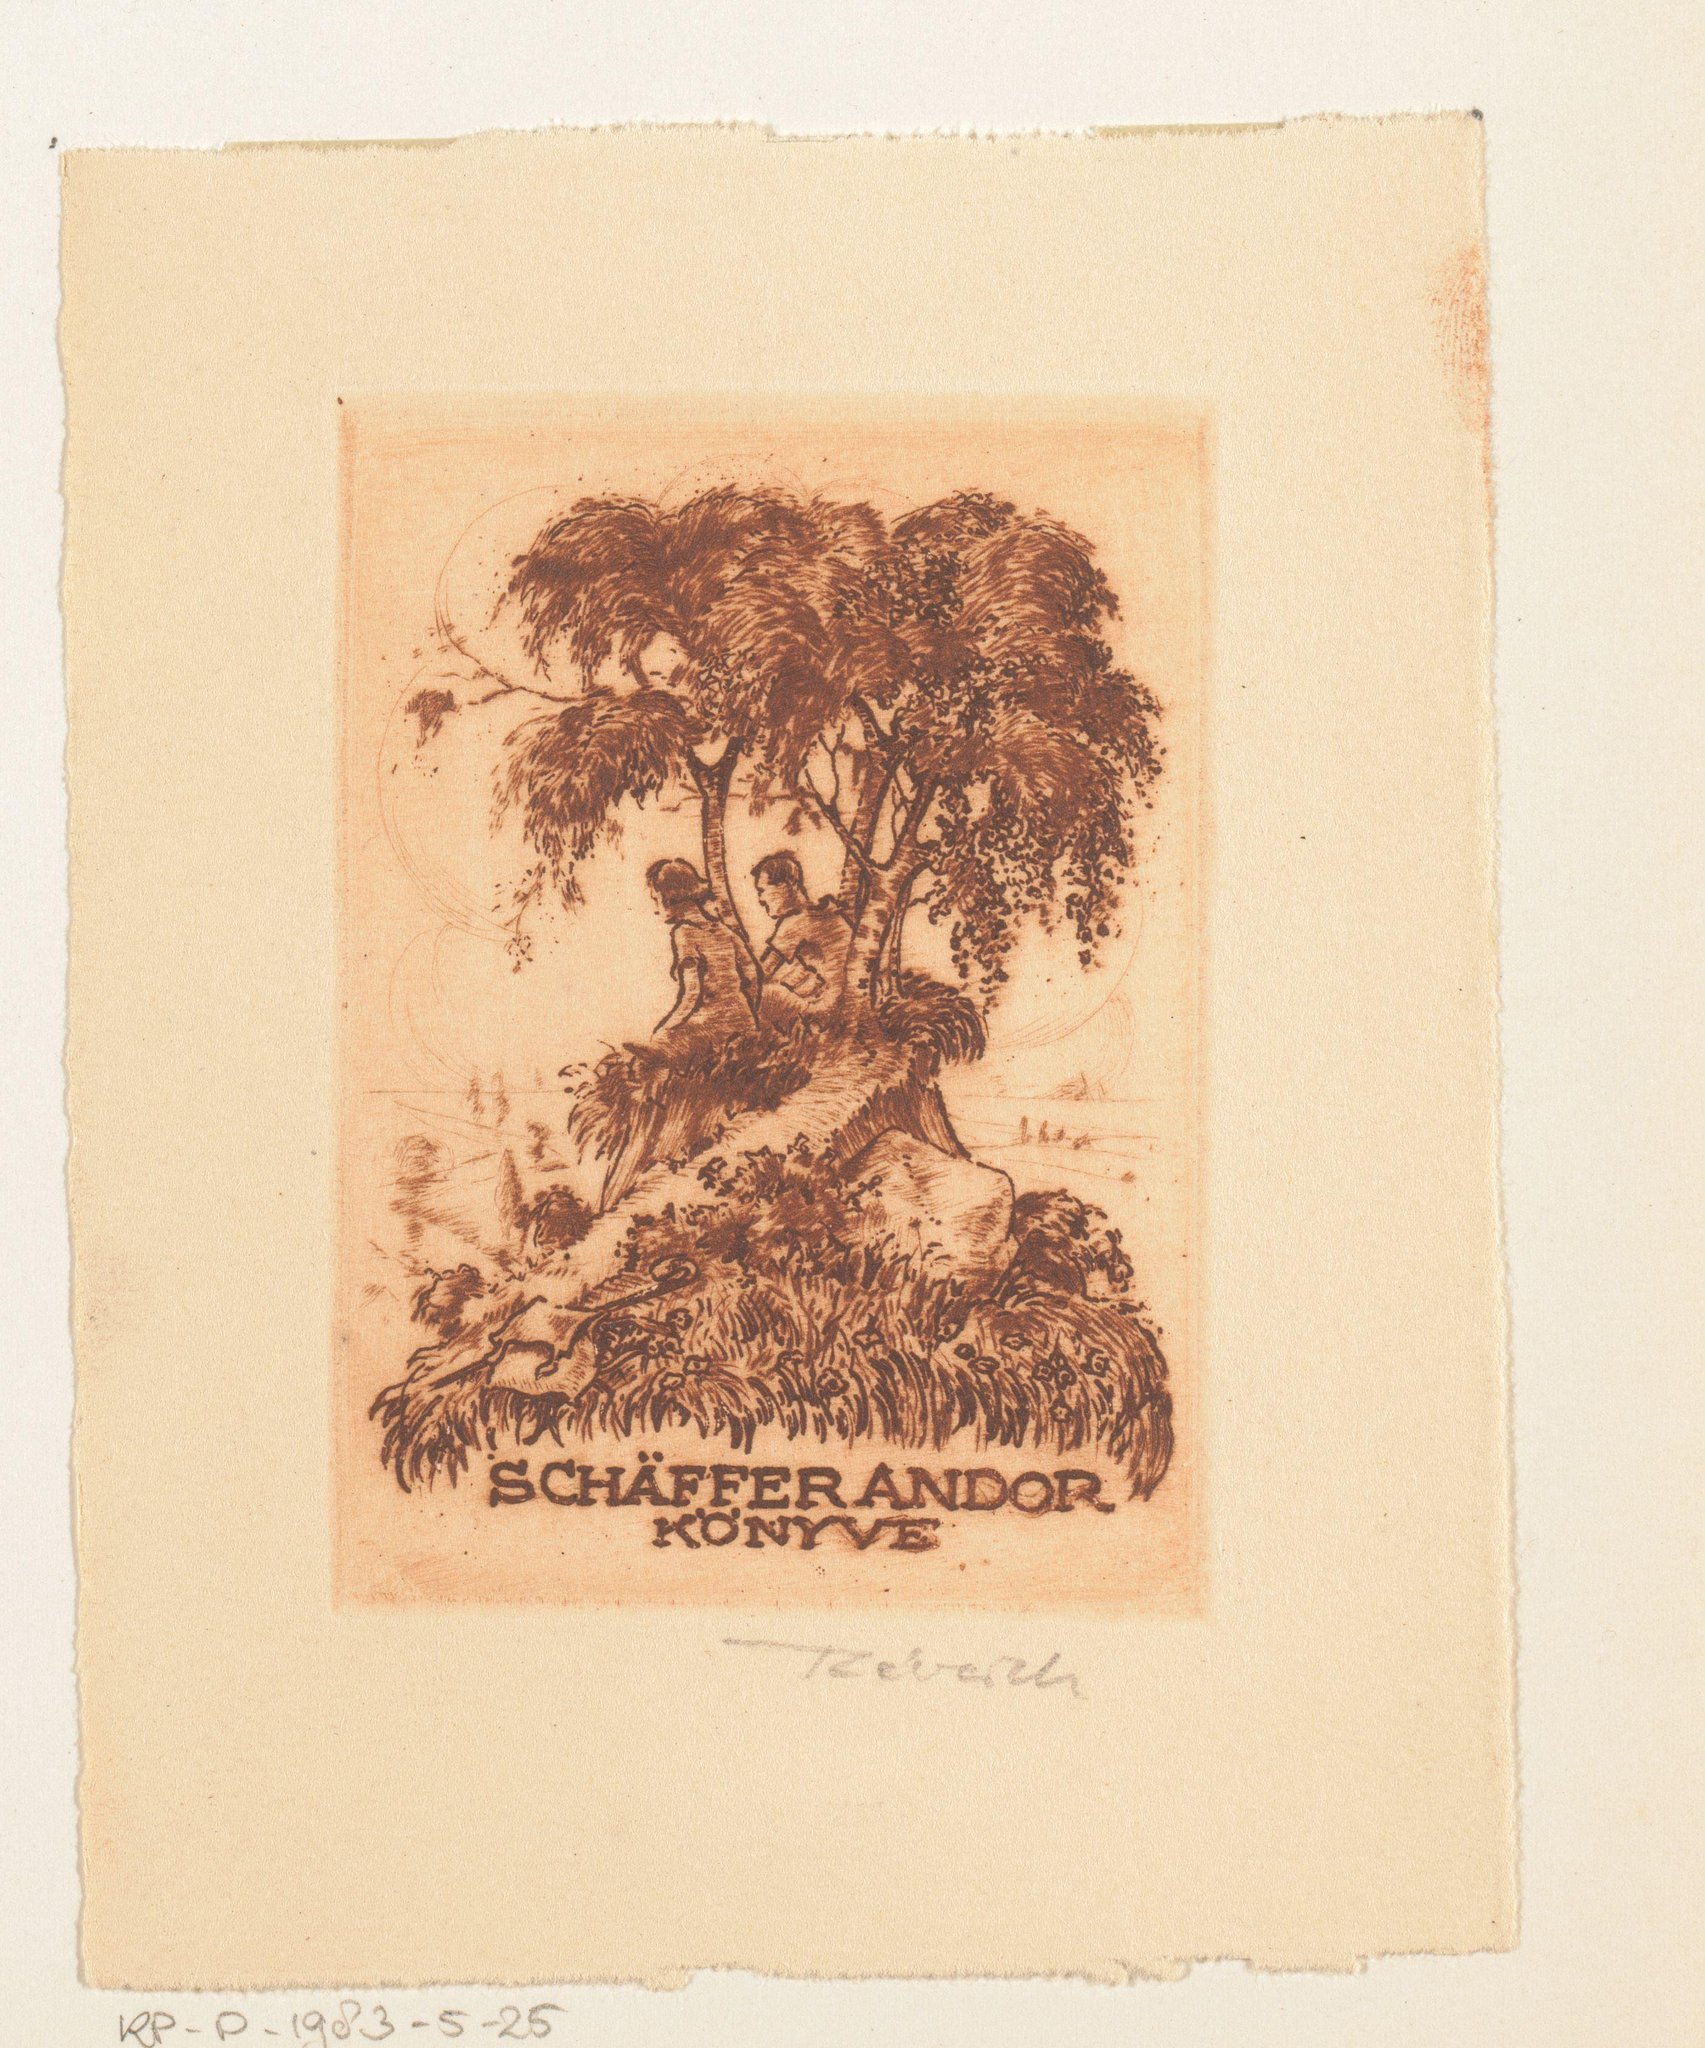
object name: bookplate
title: Schäffer Andor könyve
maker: kornél révész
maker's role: print maker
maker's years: 1885-1944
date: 1935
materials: paper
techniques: drypoint, etching, intaglio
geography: budapest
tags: print maker, andor schäffer, trees, landscapes, couple of lovers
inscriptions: date: ‘Nr. 113/ 1935’, signature: ‘Révész’, workshop stamp: ‘Fecit/ Révész Kornél/ Budapest’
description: Ex libris maakt deel uit van omslag met 64 ex libris op 34 losse opzetvellen, een catalogus en een tekstblad.